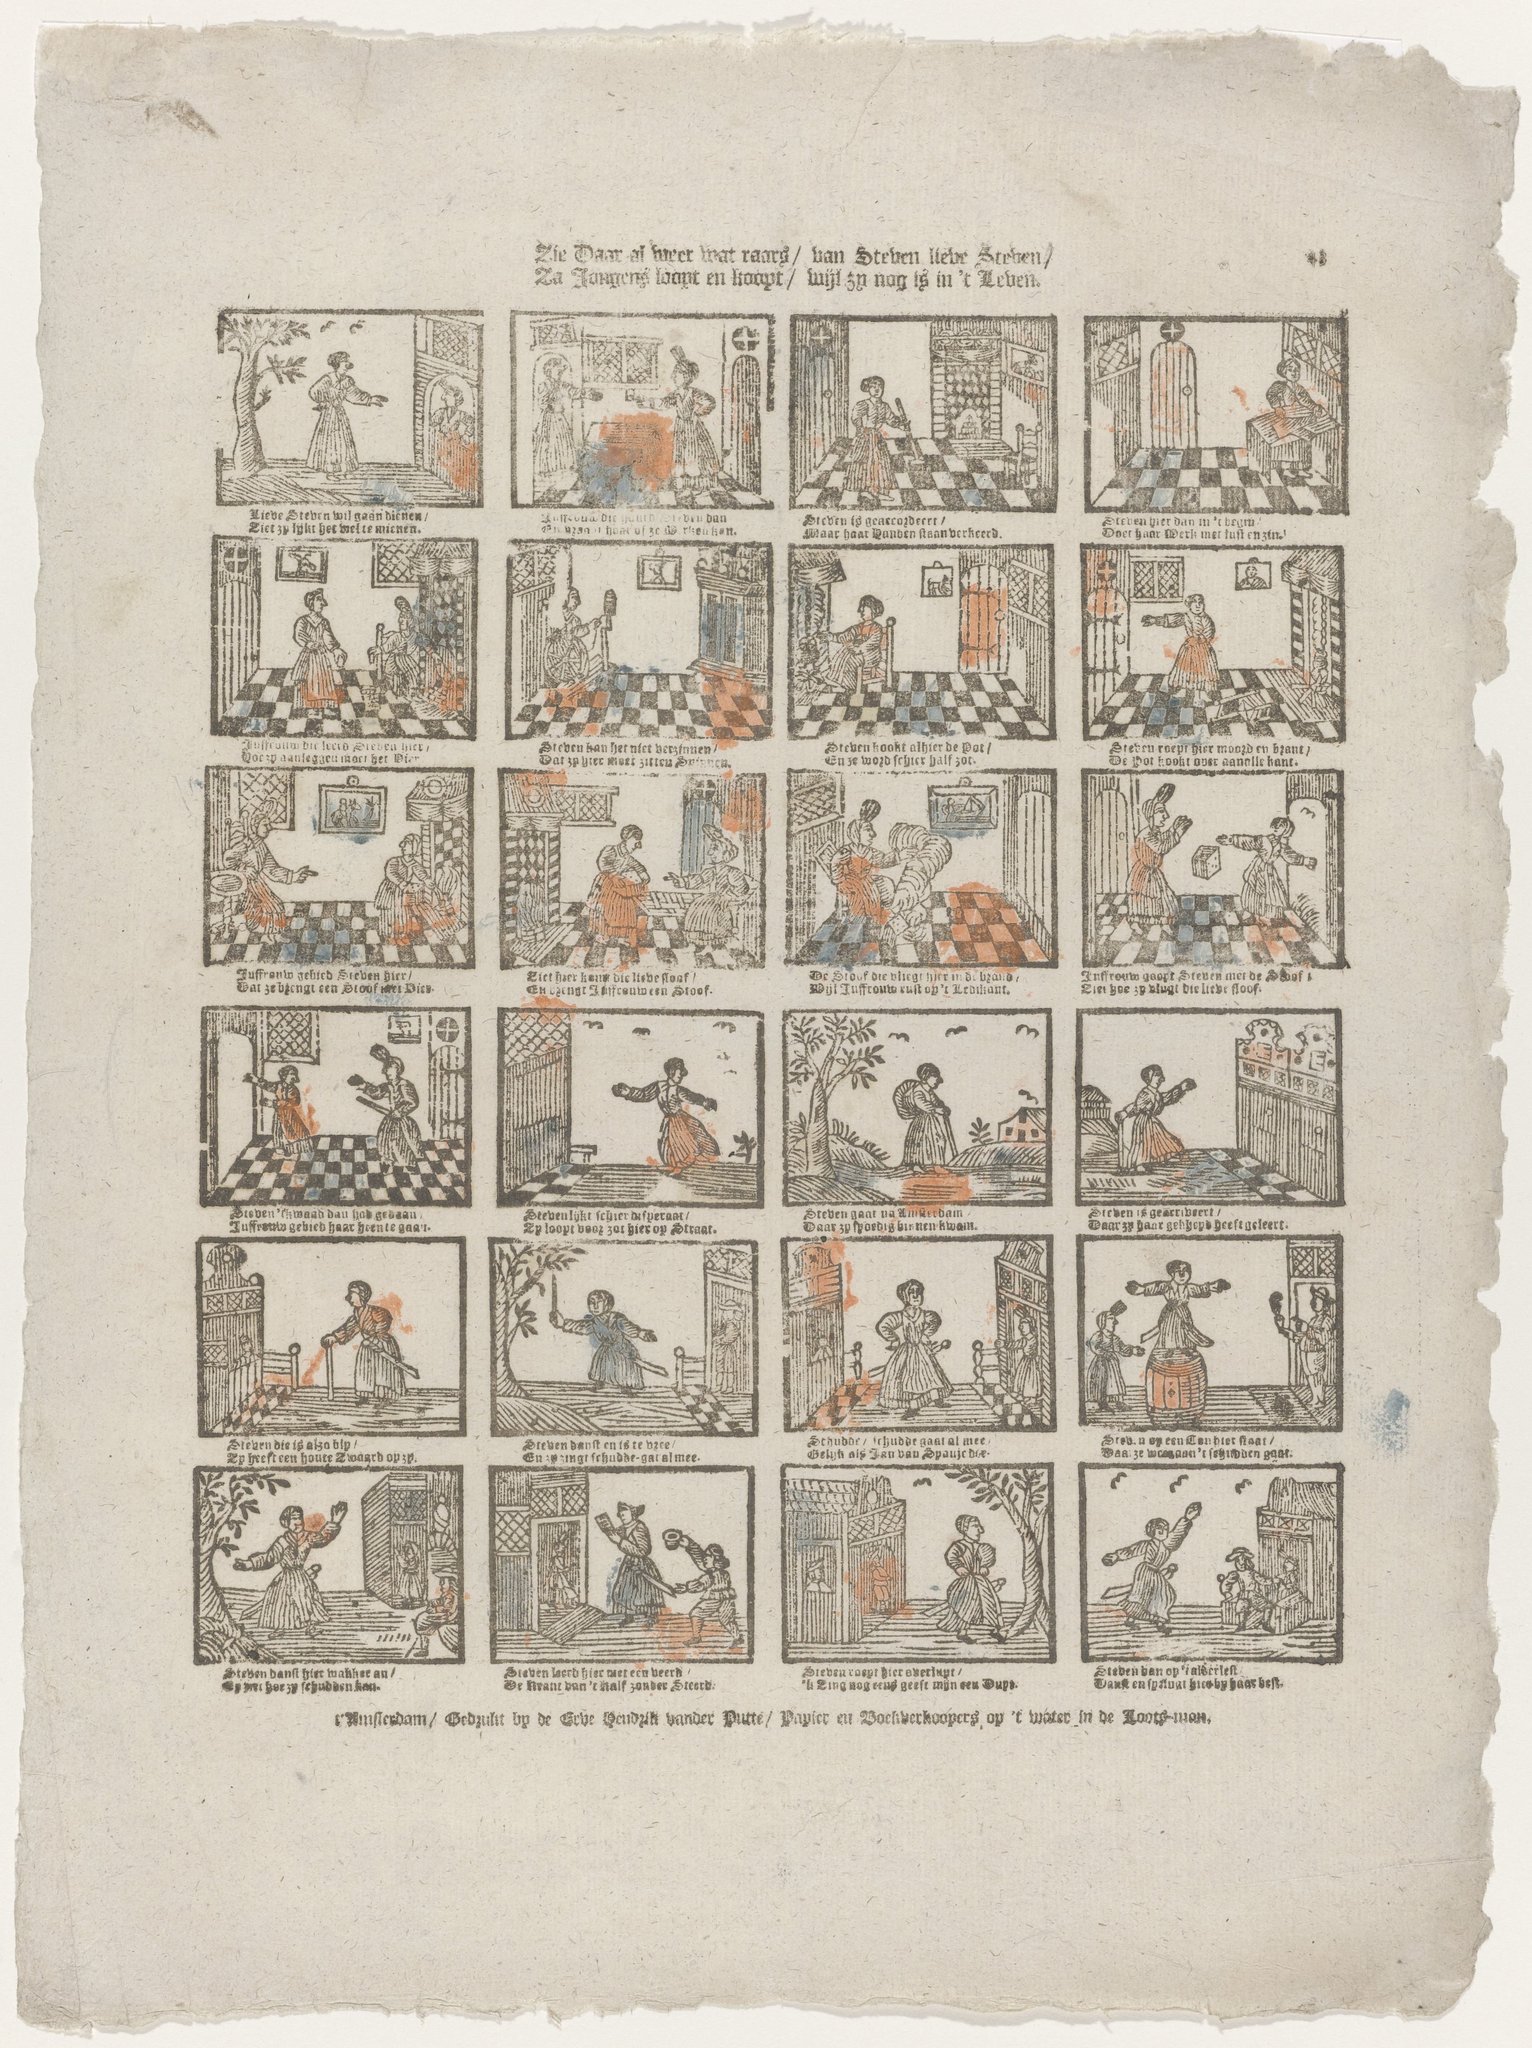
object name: print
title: Zie daar al weer wat raars / van Steven lieve Steven / Za jongens loopt en koopt / wijl zy nog is in 't leven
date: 1767-1793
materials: paper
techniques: colour, letterpress printing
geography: netherlands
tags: maid ~ house personnel, kitchen-maid, kitchen servant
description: Uitgave van nr. 43 uit de fondslijst van Johannes Kannewet (II) met het adres van de wederverkoper Erven Hendrik van der Putte.